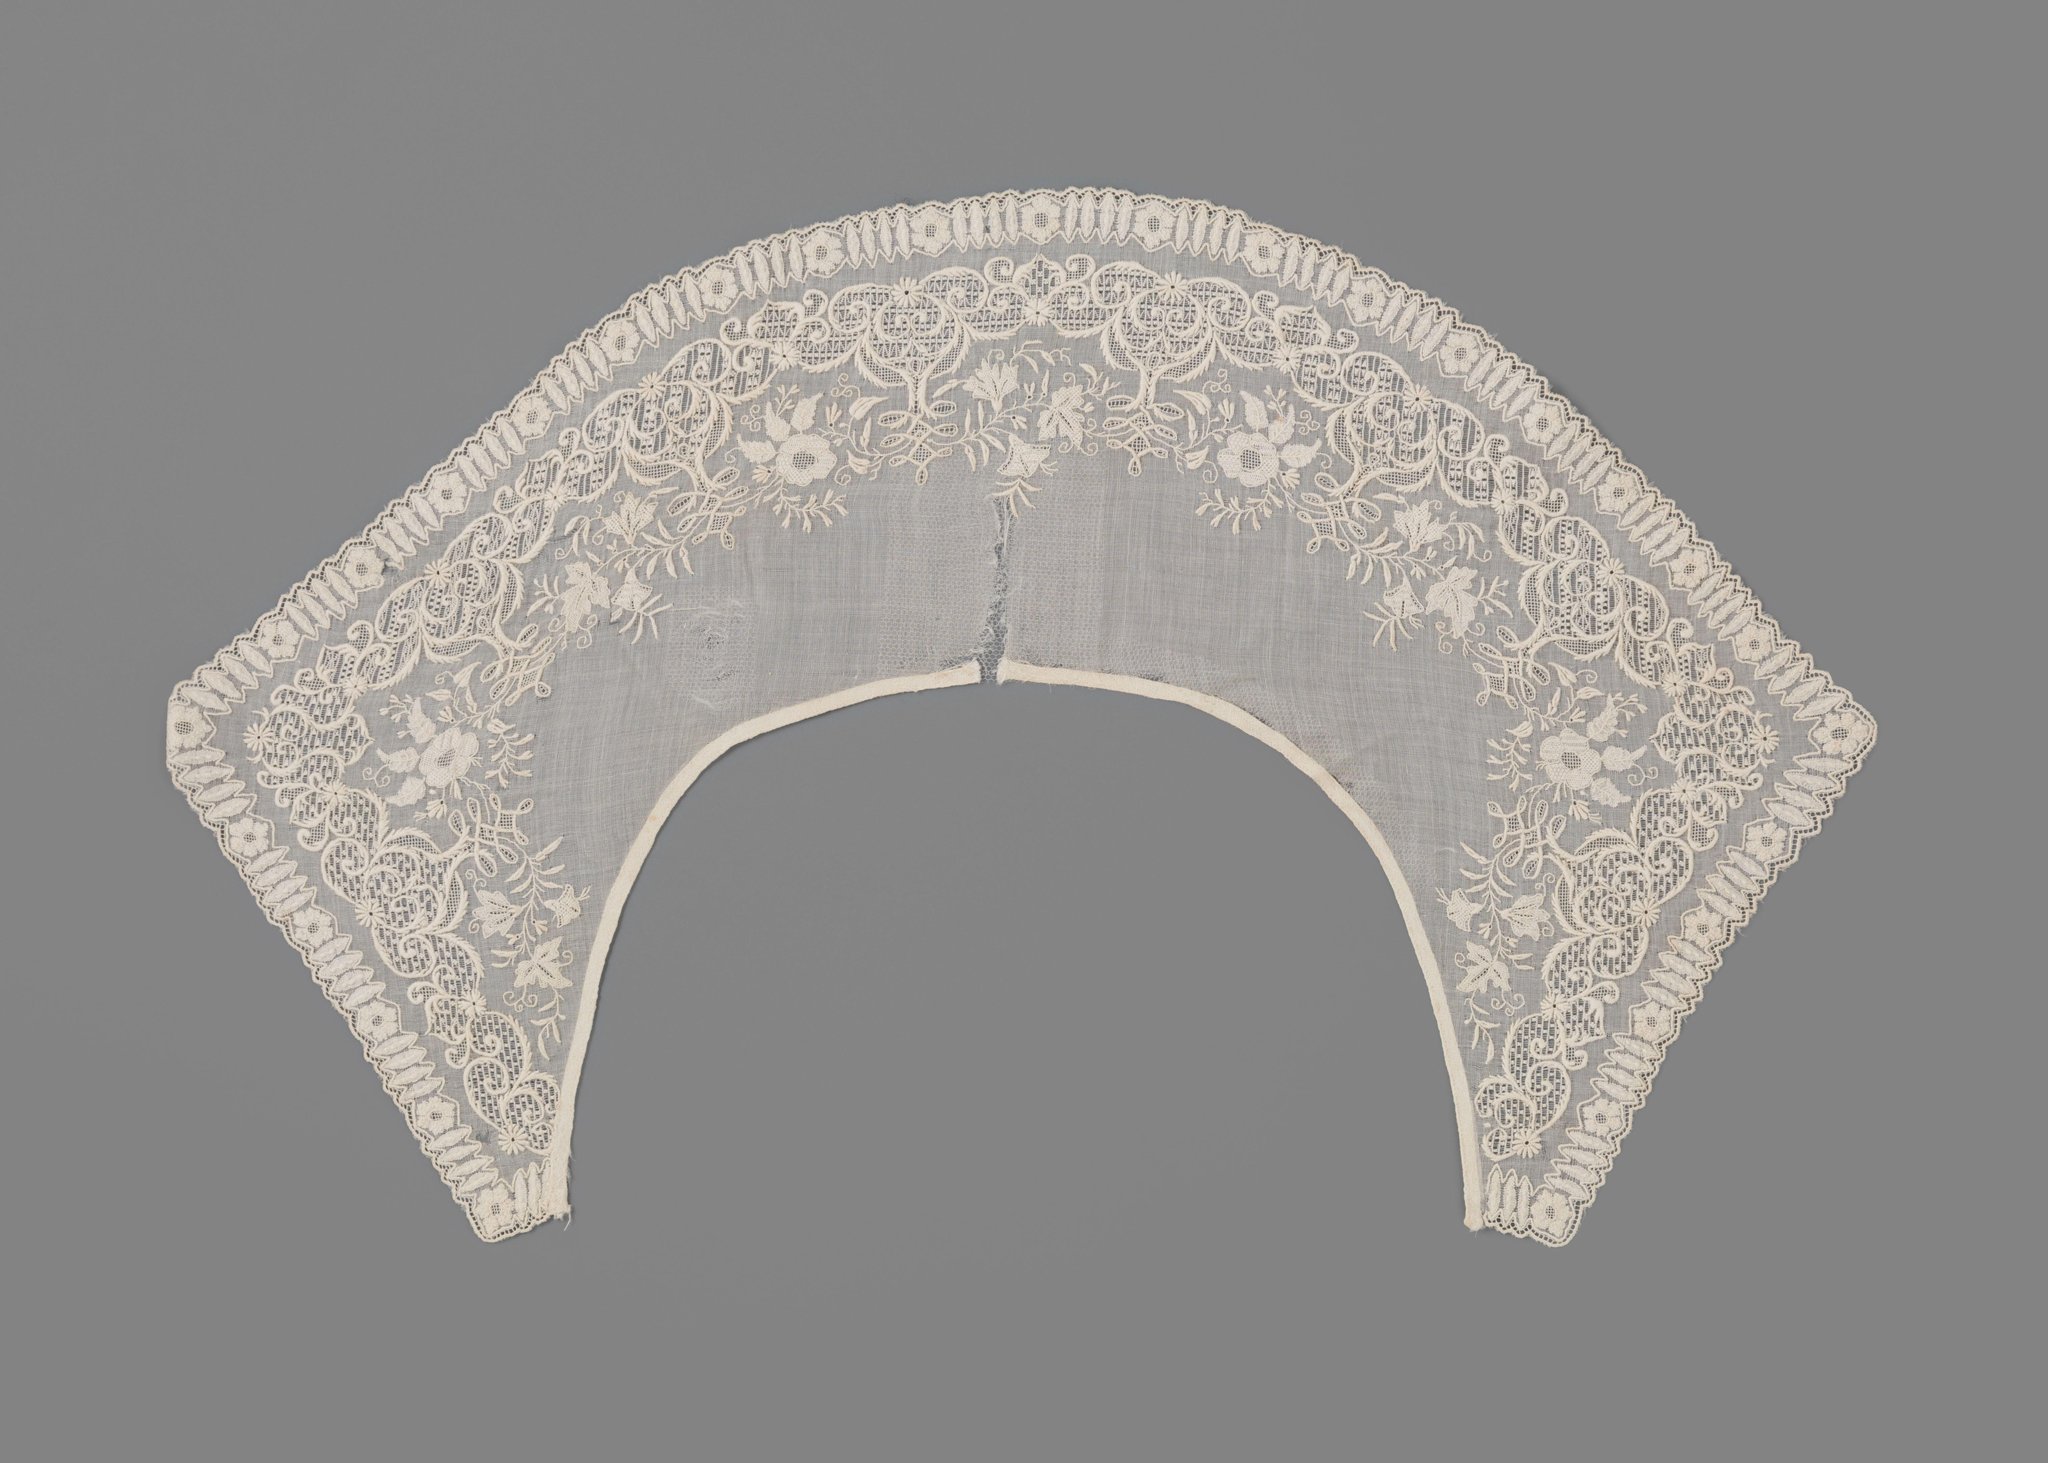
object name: womenswear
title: Kraag met borduurwerk en naaldkant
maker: Anonymous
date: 1850-1930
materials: linen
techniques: embroidery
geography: western europe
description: Kraag met borduurwerk en naaldkant, de rand is licht getand.